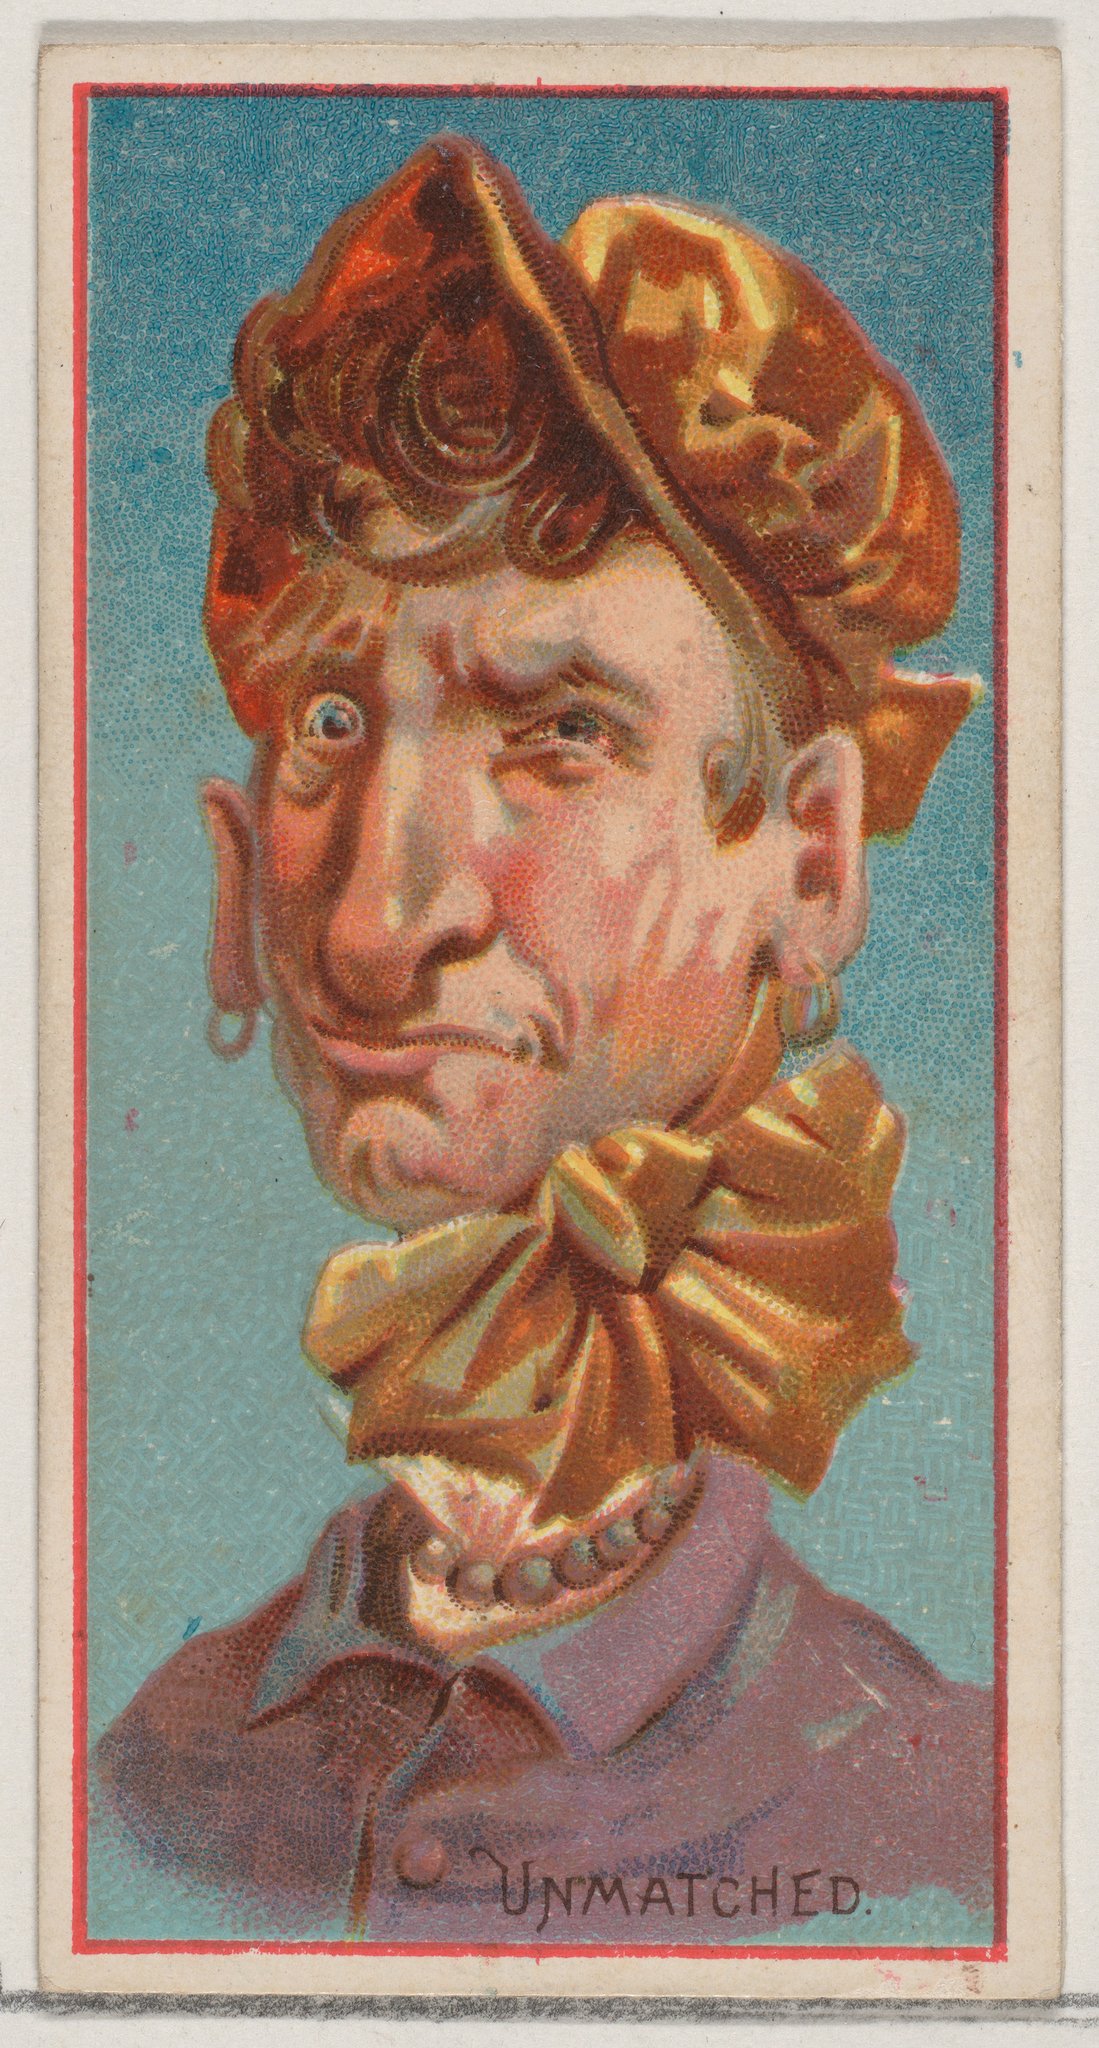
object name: print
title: Unmatched, from the Jokes series (N87) for Duke brand cigarettes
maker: w. duke, sons & co.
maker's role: publisher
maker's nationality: american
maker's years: 1870-1920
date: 1890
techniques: color lithograph